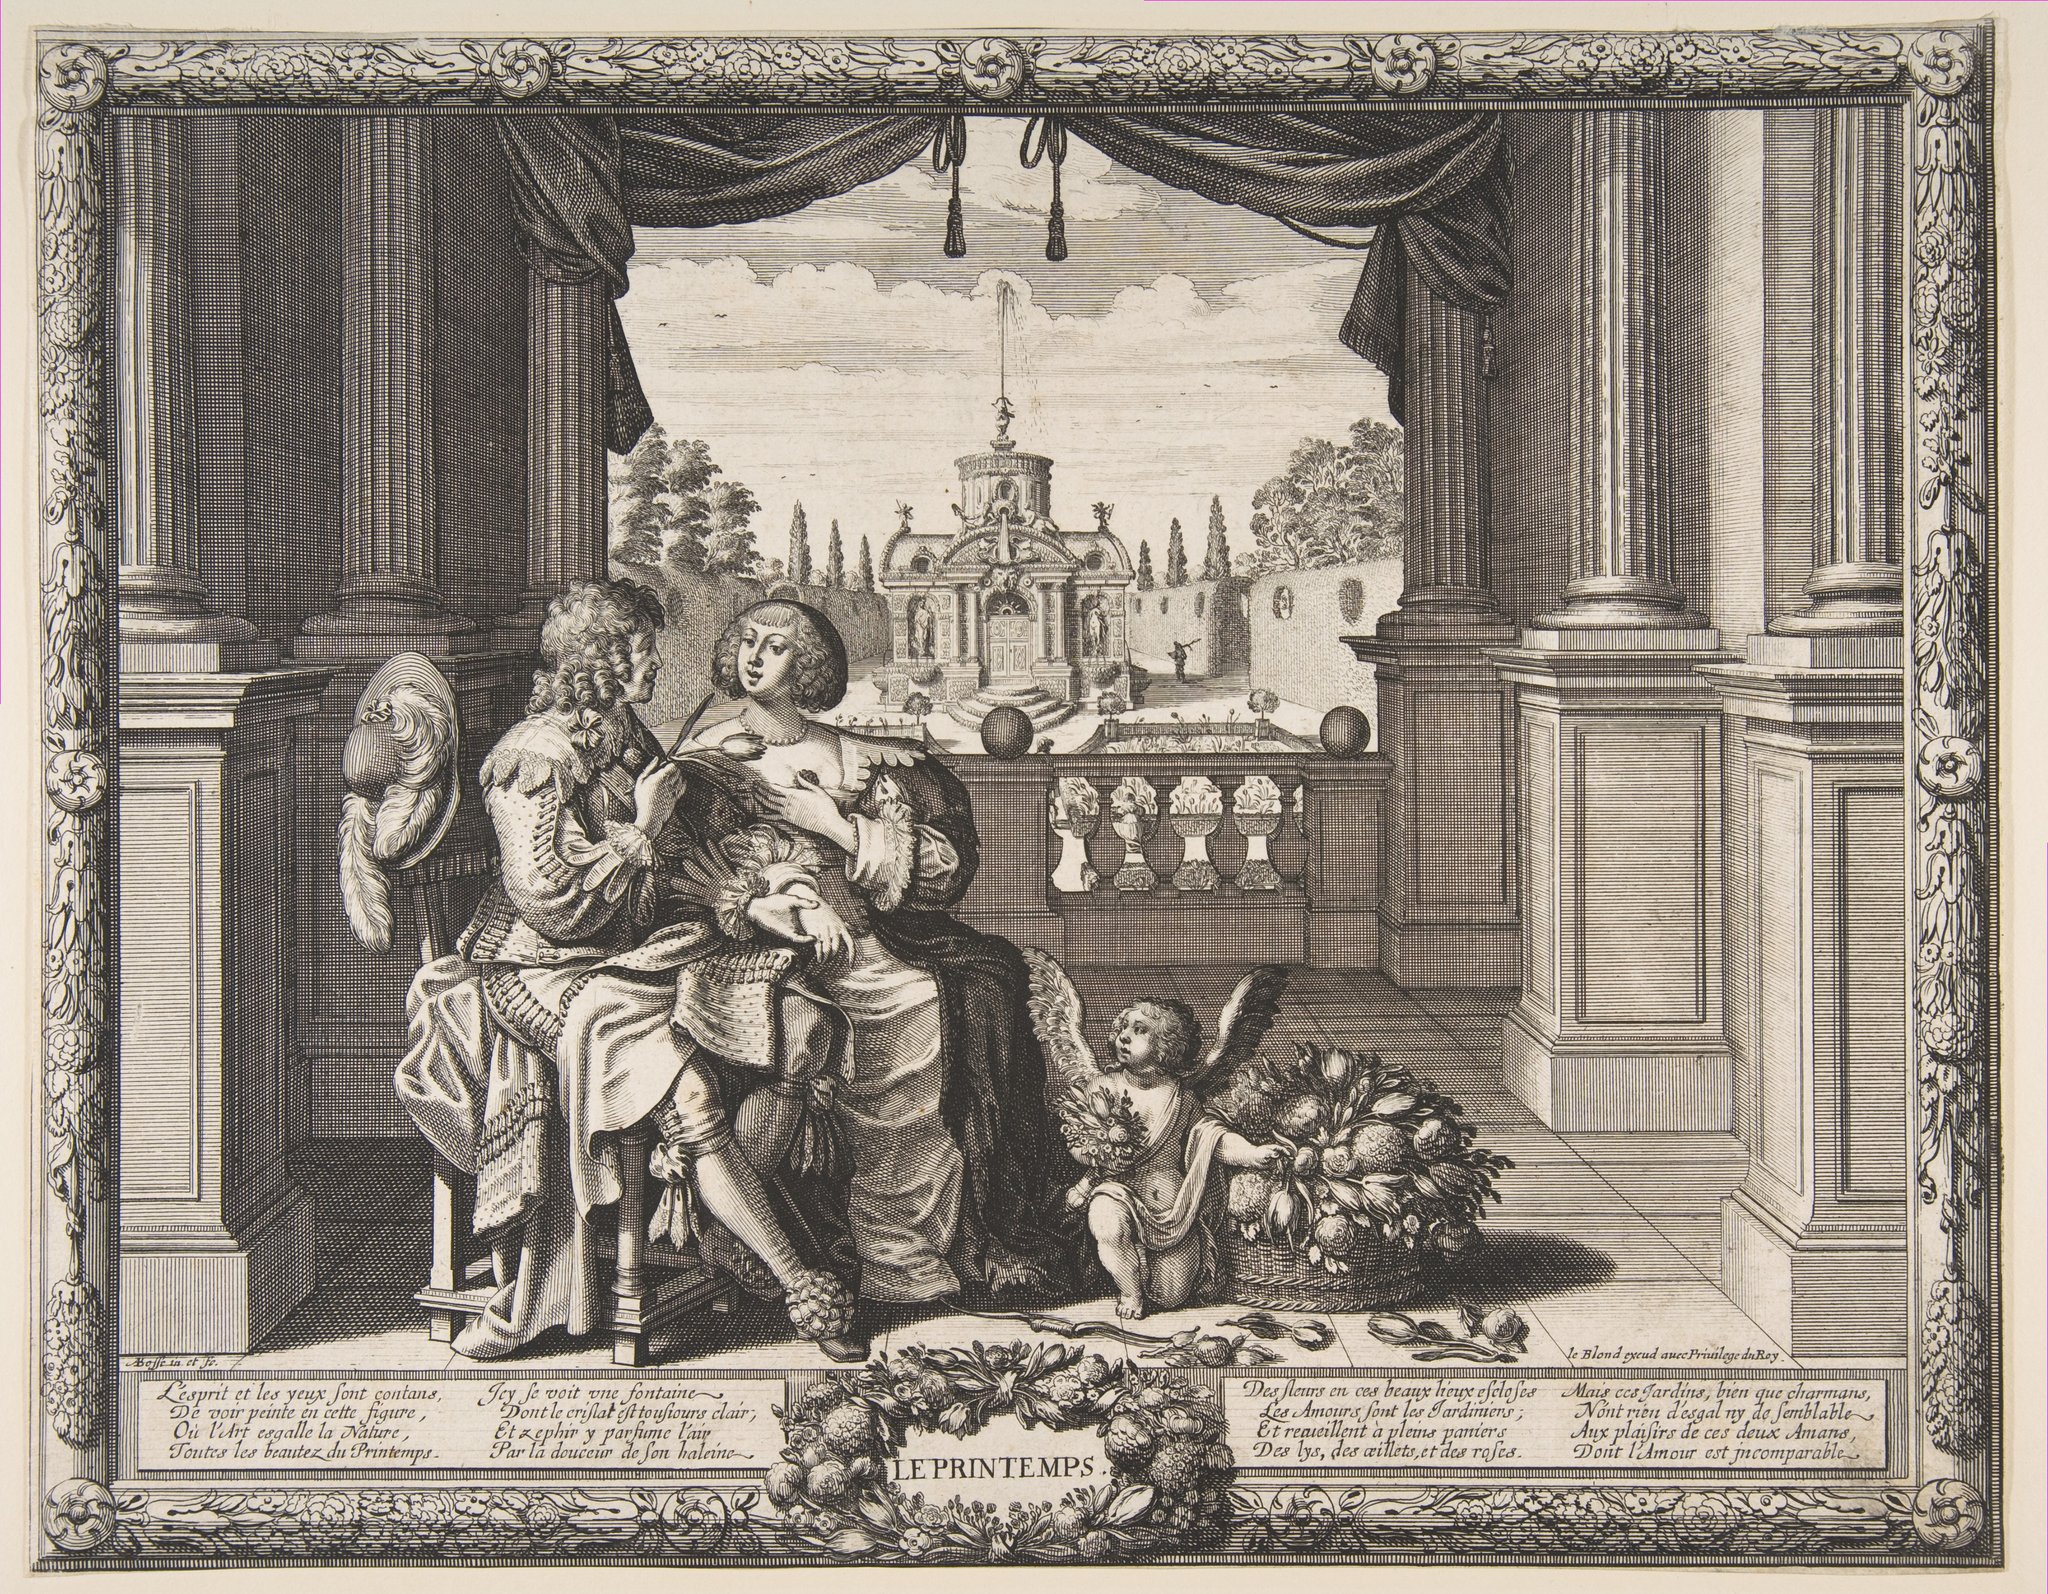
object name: print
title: Spring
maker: abraham bosse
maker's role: artist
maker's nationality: french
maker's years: 1602-1676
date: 1637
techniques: etching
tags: buildings,men,women,mythical creatures,wreaths